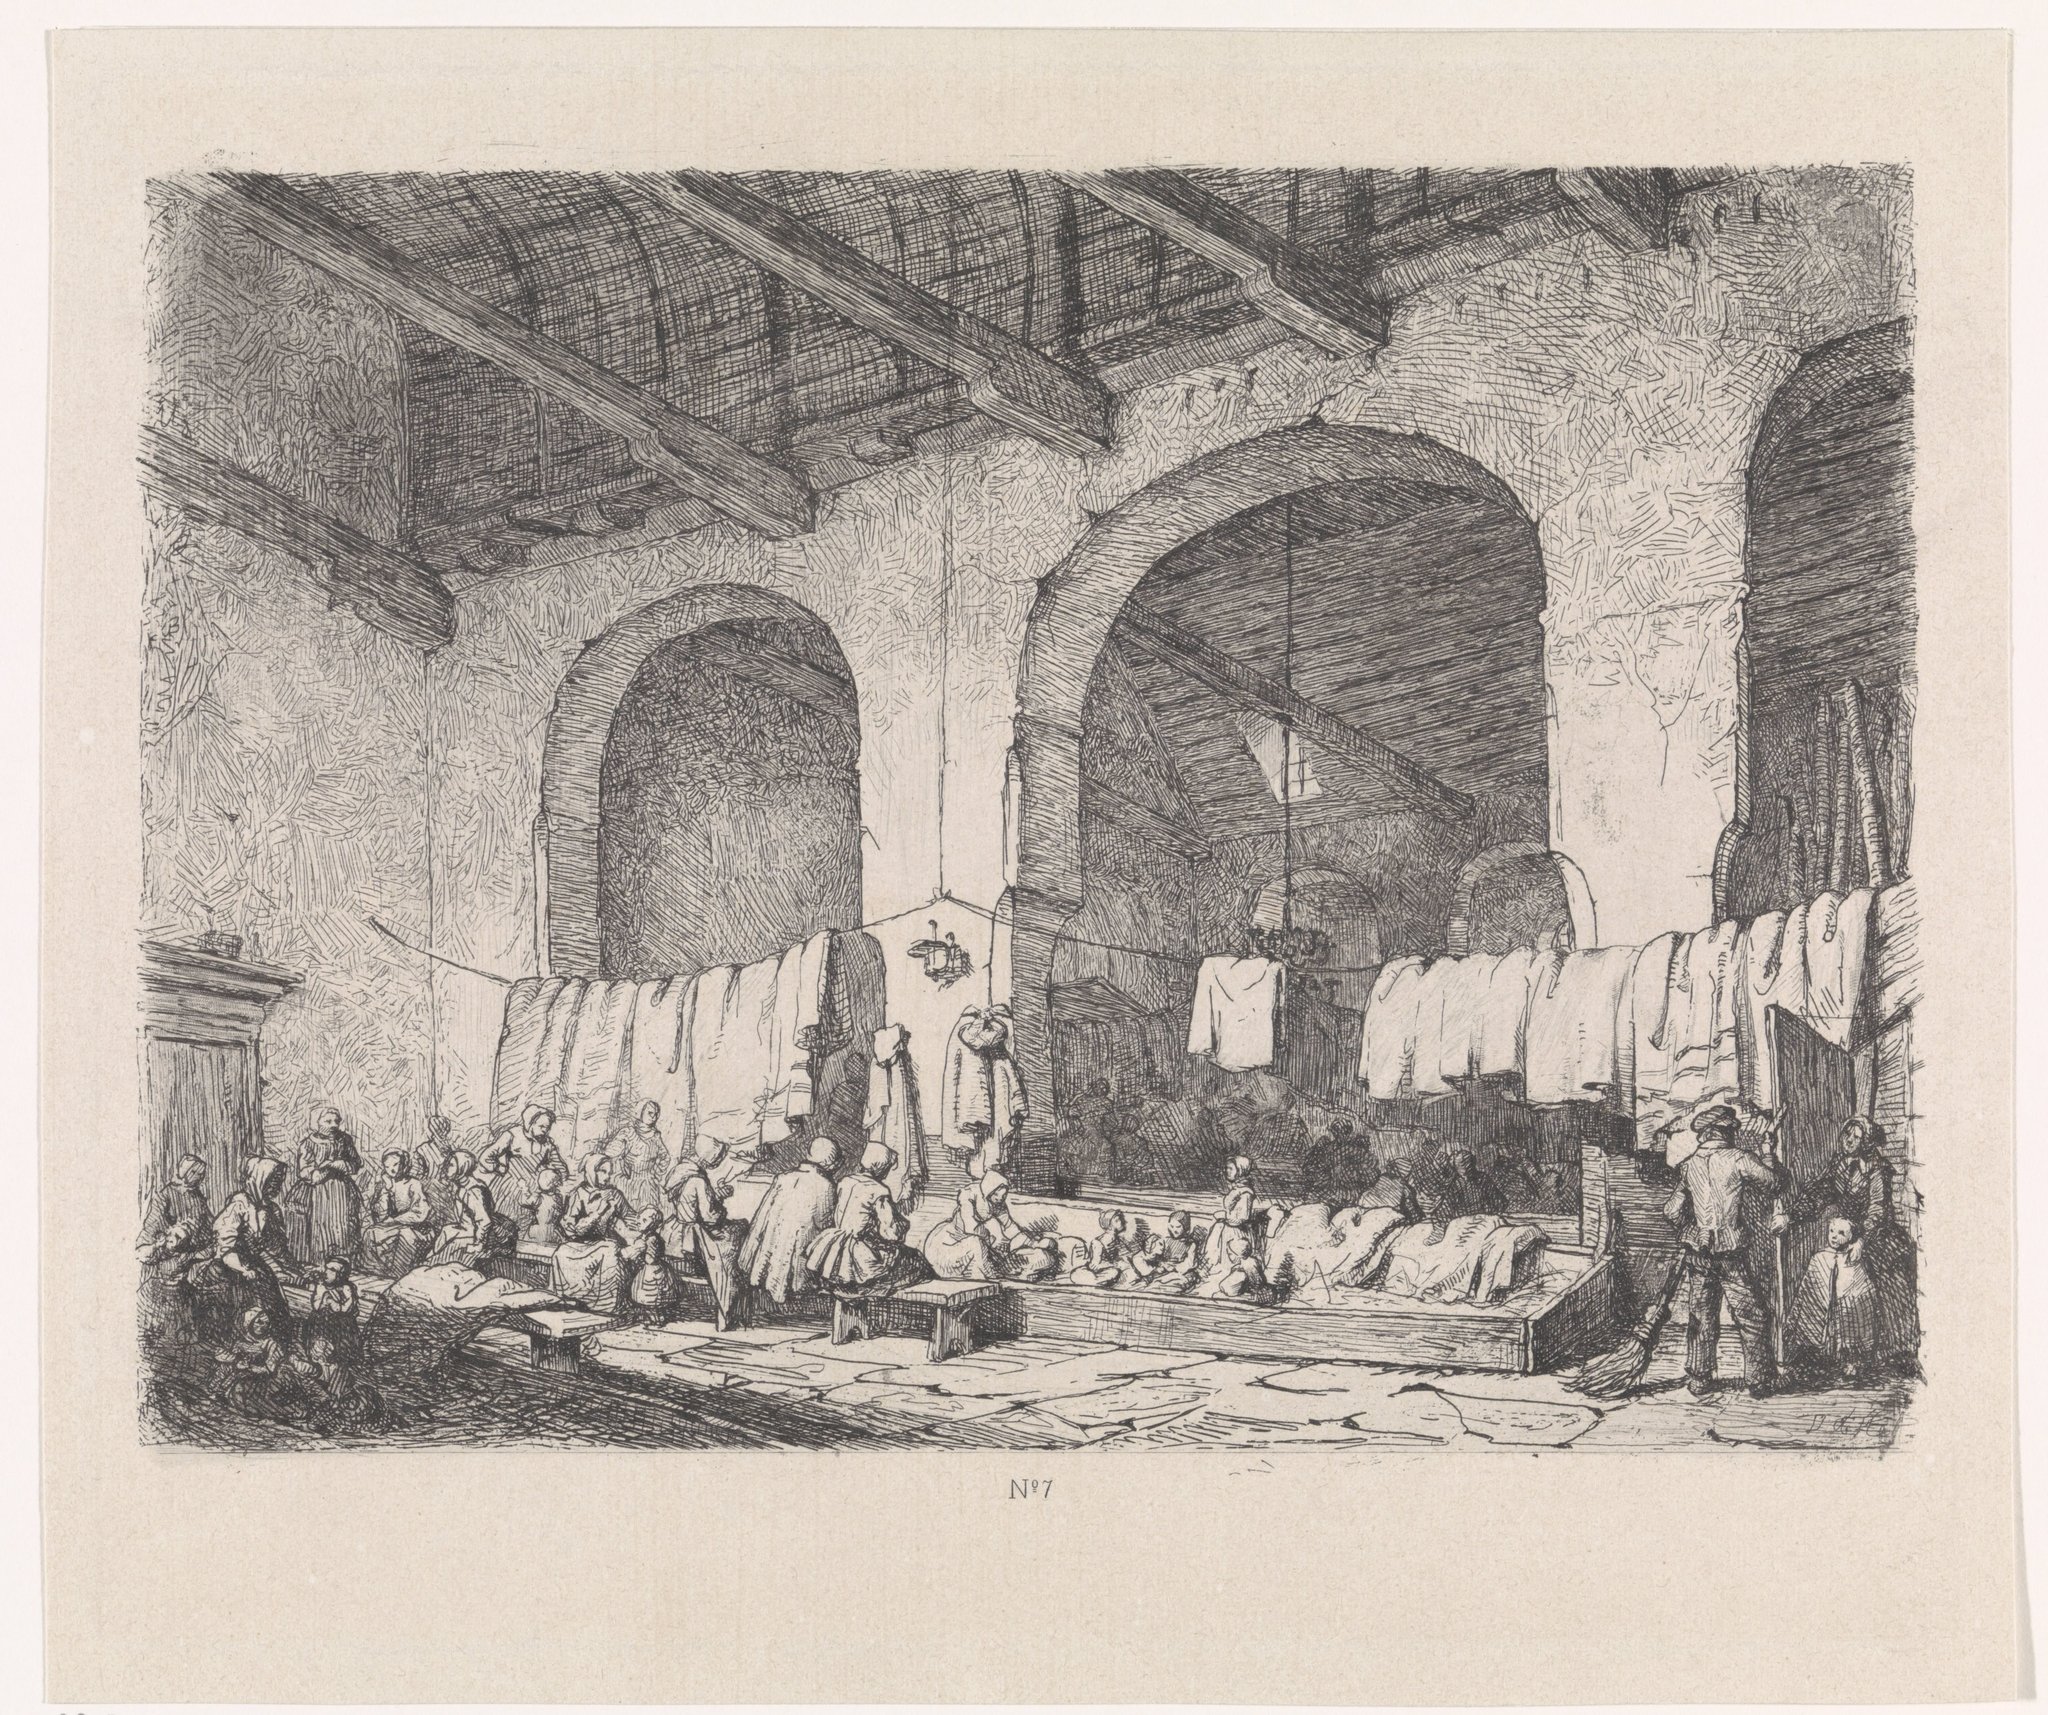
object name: print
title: Slachtoffers van de watersnoodramp in de Geertekerk te Utrecht, 1855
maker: david van der kellen (1827-1895)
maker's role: draughtsman, print maker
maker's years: 1827-1895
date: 1855-1860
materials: paper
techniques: drypoint, etching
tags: utrecht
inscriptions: collector's mark: Lugt 2228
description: In de Geertekerk te Utrecht bevinden zich slachtoffers van de watersnoodramp van 1855. Op de lange banken zitten voornamelijk vrouwen en kinderen en aan twee waslijnen hangt textiel te drogen. Rechts staat een man met een bezem. Deze prent maakt deel uit van een serie.